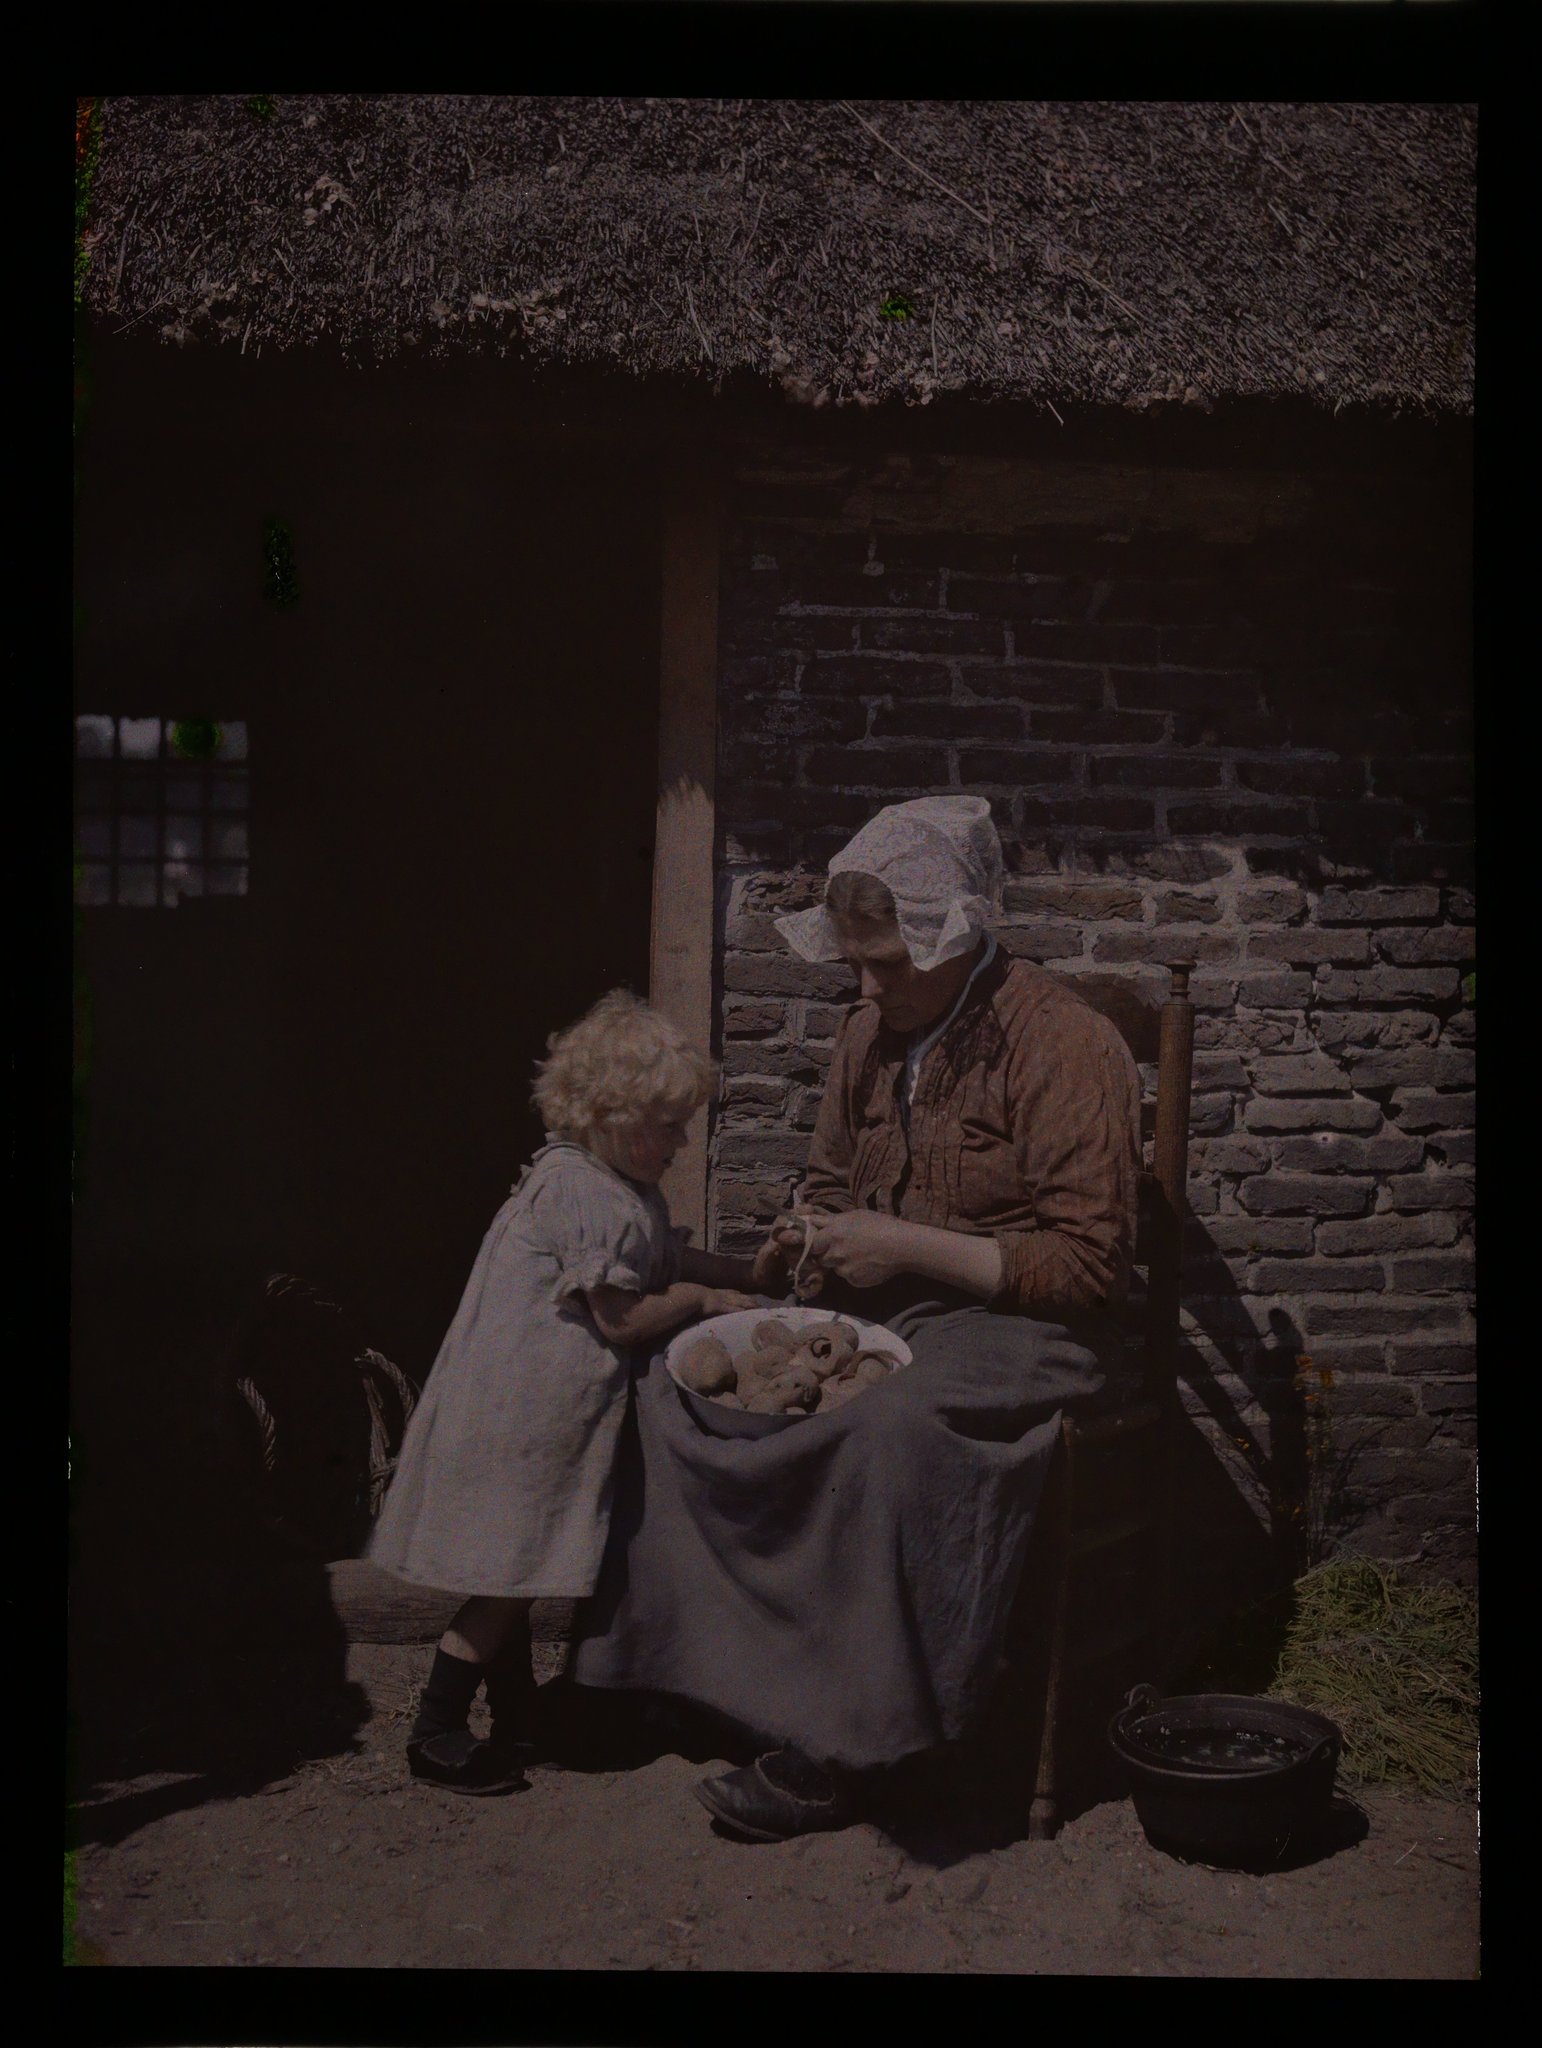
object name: photograph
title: Vrouw schilt aardappelen, een kind kijkt toe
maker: Anonymous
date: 1907-1935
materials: glass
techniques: autochrome process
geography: netherlands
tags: cleaning vegetables - cc - in the open air, netherlands